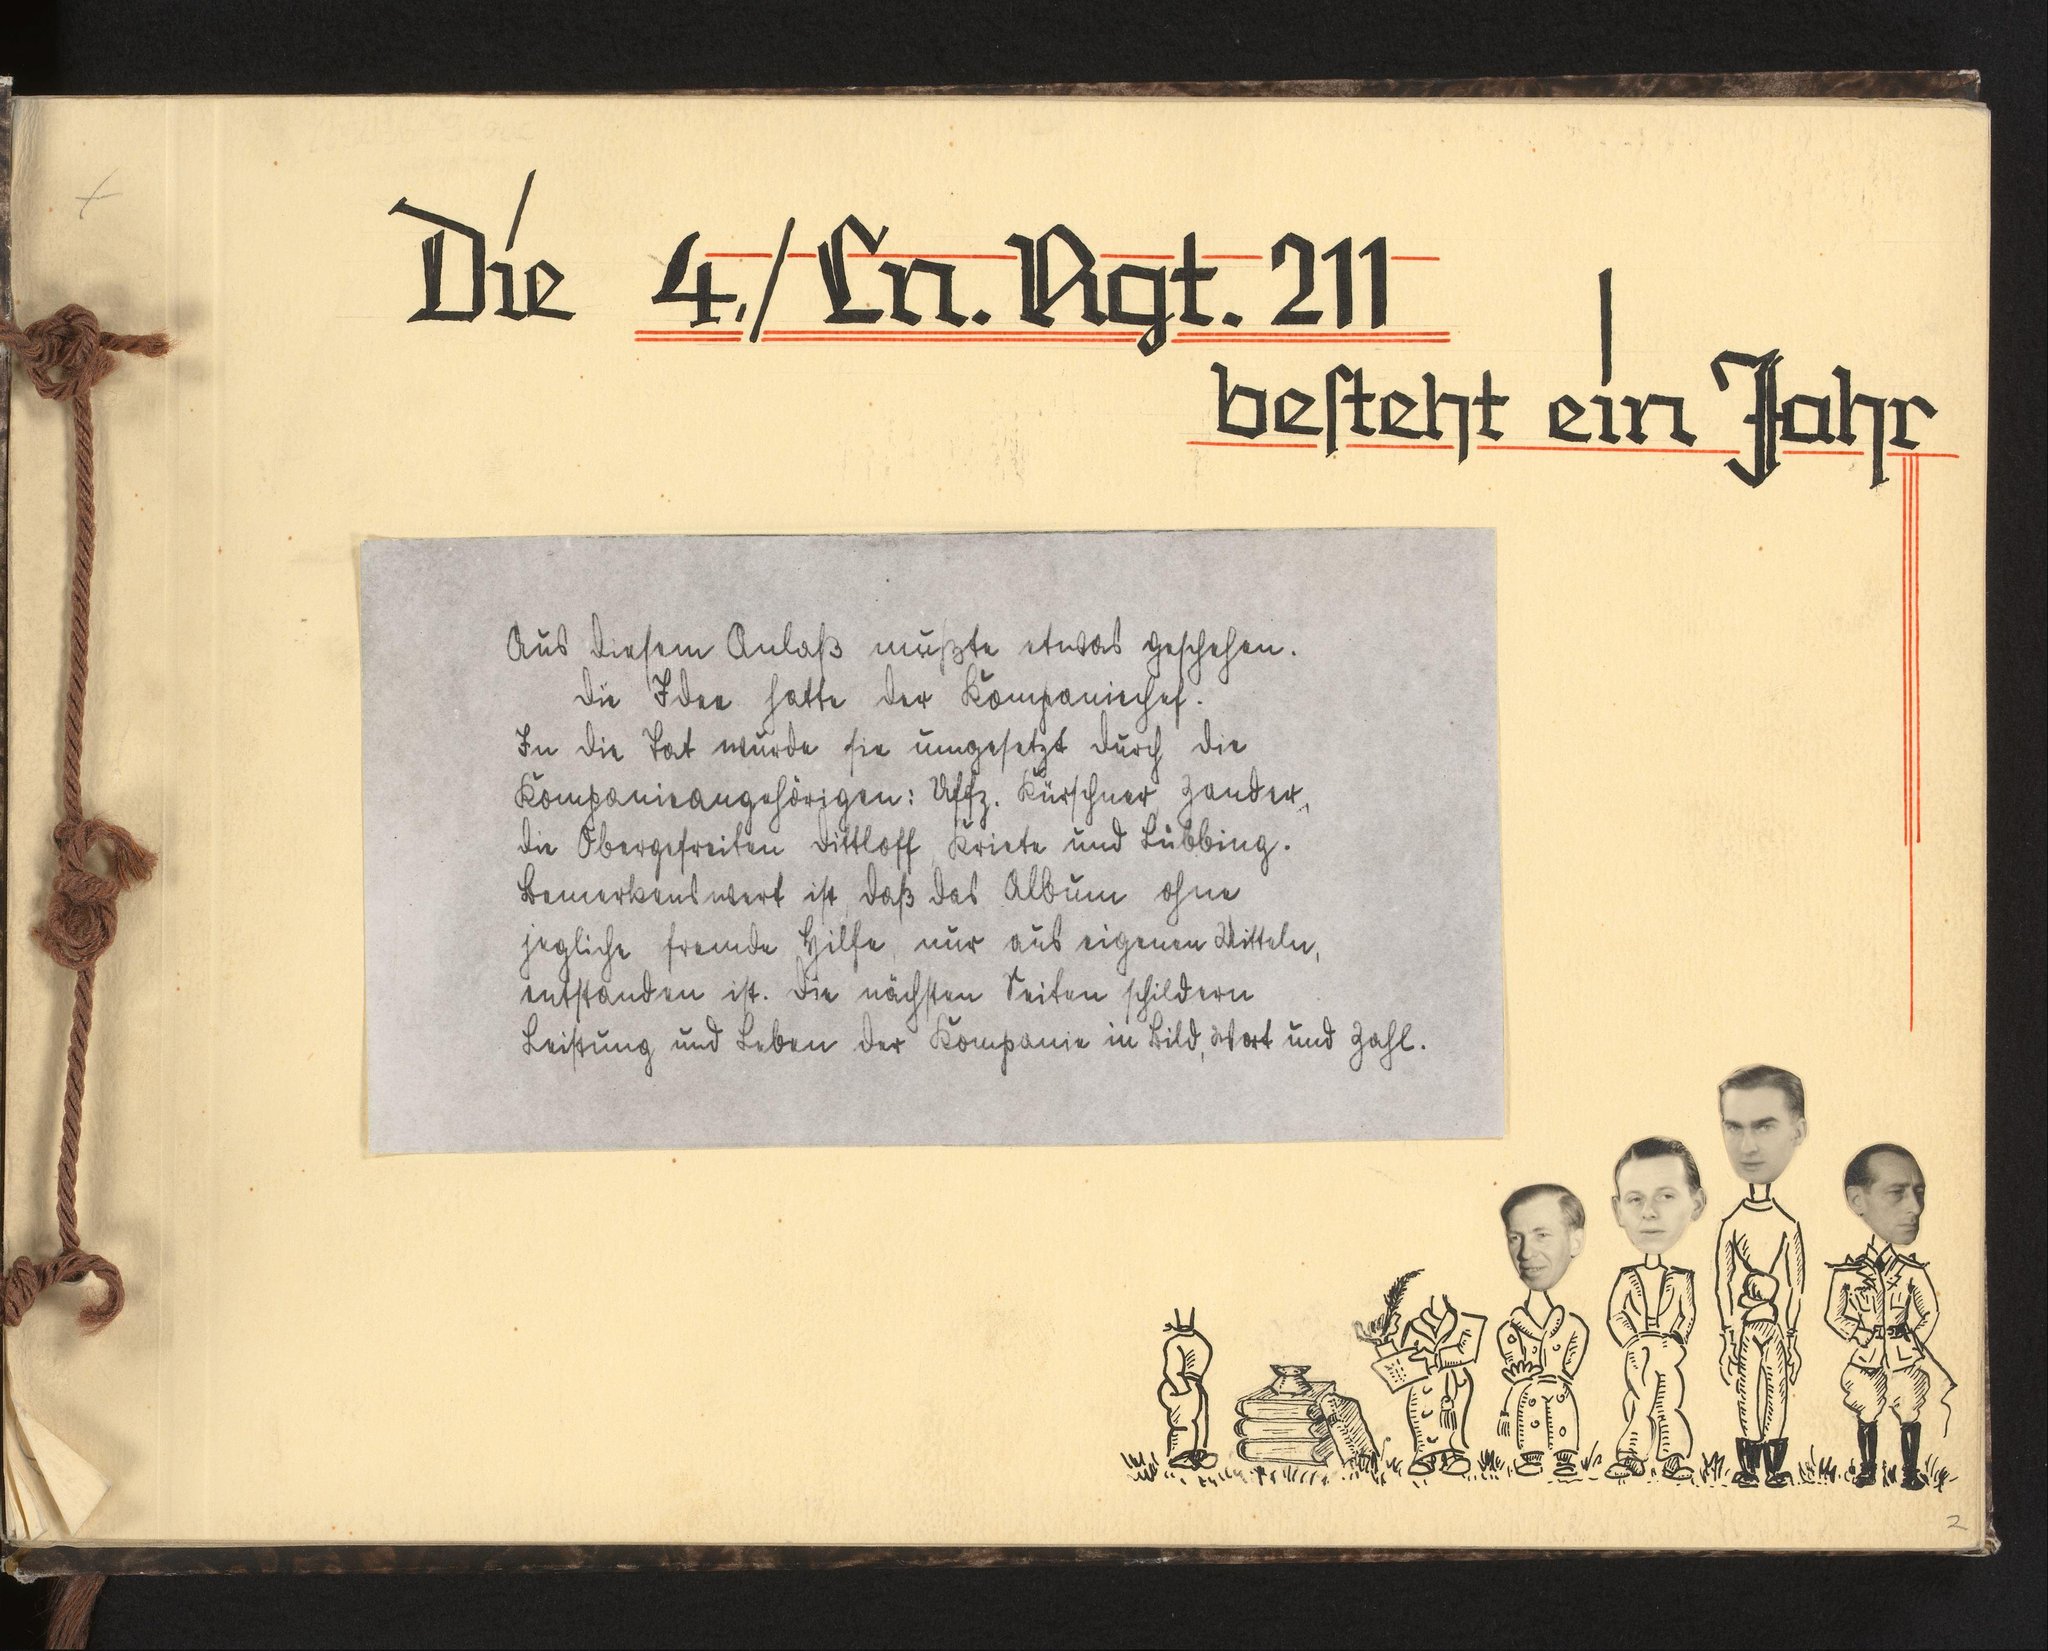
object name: titelblad, titelpagina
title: Die 4. / Ln. Rgt. 211 besteht ein Jahr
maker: Anonymous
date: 1942-1943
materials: cardboard, ink, photographic support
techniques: gelatin silver print, pen, writing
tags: luftnachrichten-regiment 211, breda, tweede wereldoorlog, bezetting van nederland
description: Albumblad met titelpagina. Onder de titel een ingeplakte foto van een tekst met rechtsonder getekende militairen met opgeplakte gefotografeerde en uitgeknipte hoofden (twee ontbreken). ONderdeel van het fotoalbum van de Luftnachrichten-Regiment 211,1942-1943.